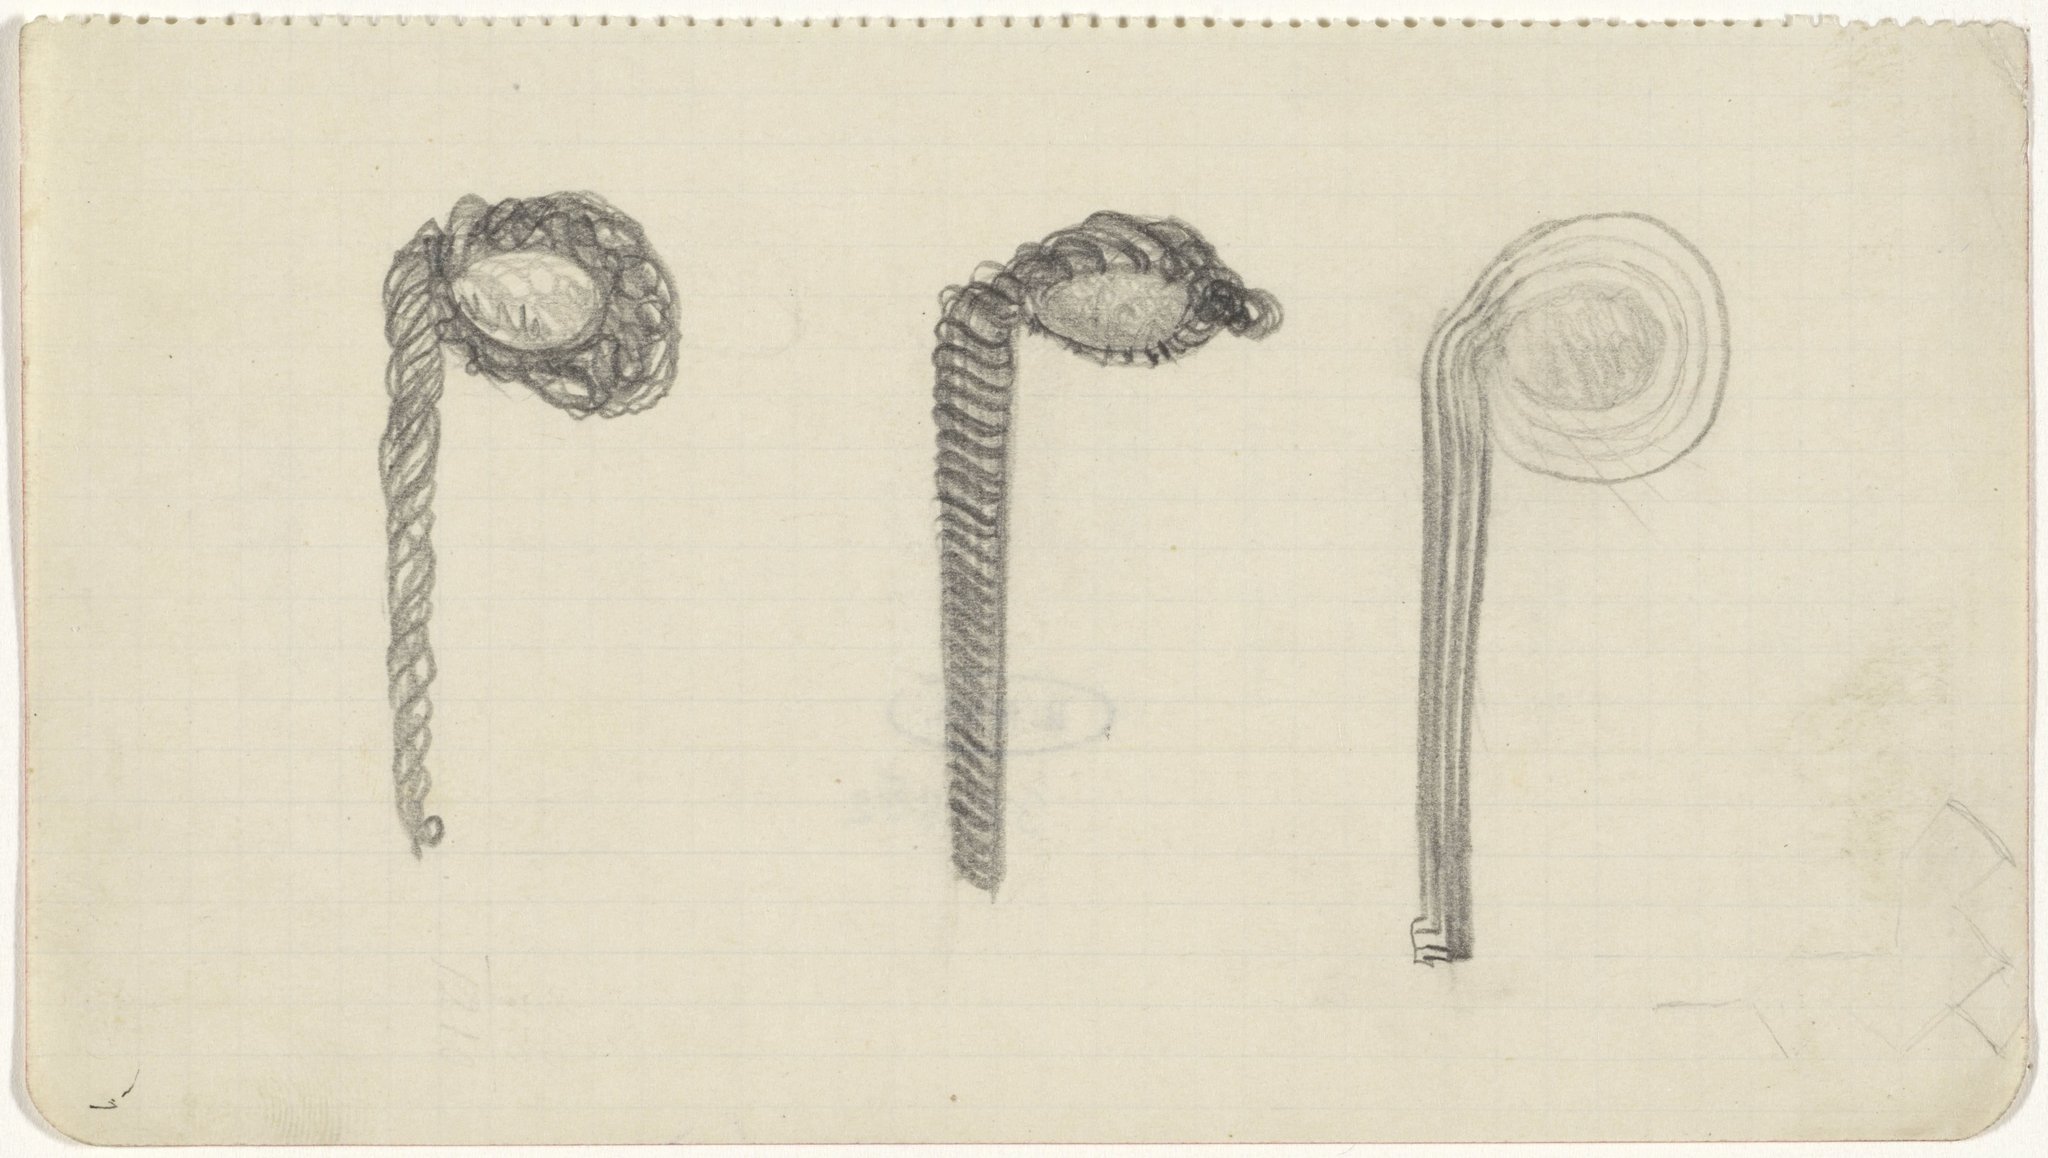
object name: drawing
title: Ontwerpen voor een sieraad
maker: mathieu lauweriks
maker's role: designer, draughtsman, print maker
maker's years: 1864-1932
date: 1874-1932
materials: pencil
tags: ornaments, jewels